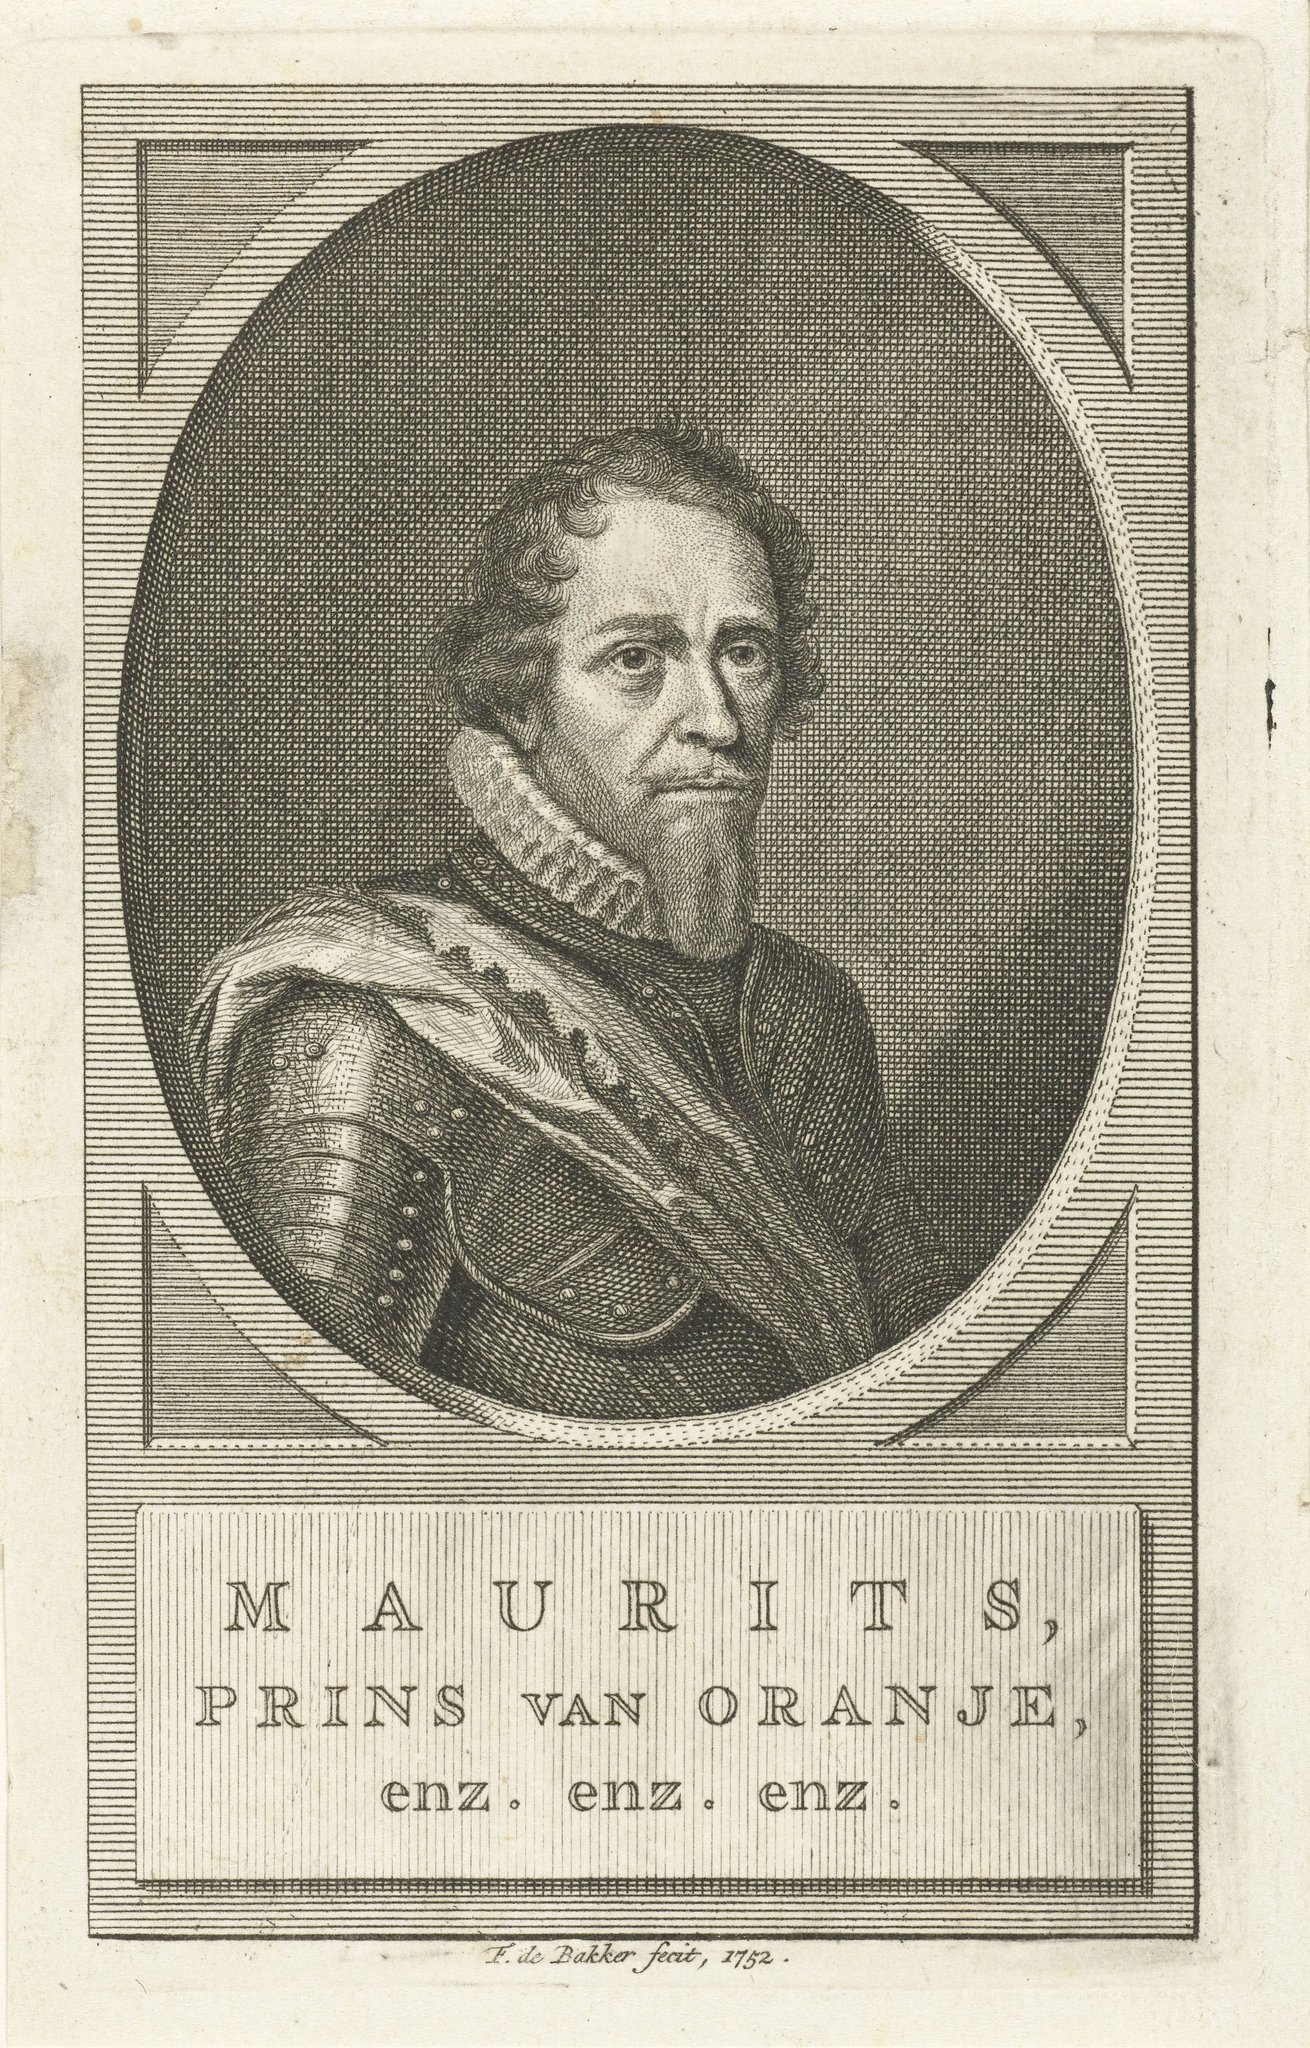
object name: print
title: Portret van Maurits, prins van Oranje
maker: frans de bakker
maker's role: print maker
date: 1752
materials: paper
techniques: etching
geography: amsterdam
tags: the hague, maurice (prince of orange)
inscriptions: collector's mark: Lugt 2228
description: Portret van Maurits prins van Oranje in ovaal. Onder het portret zijn naam.